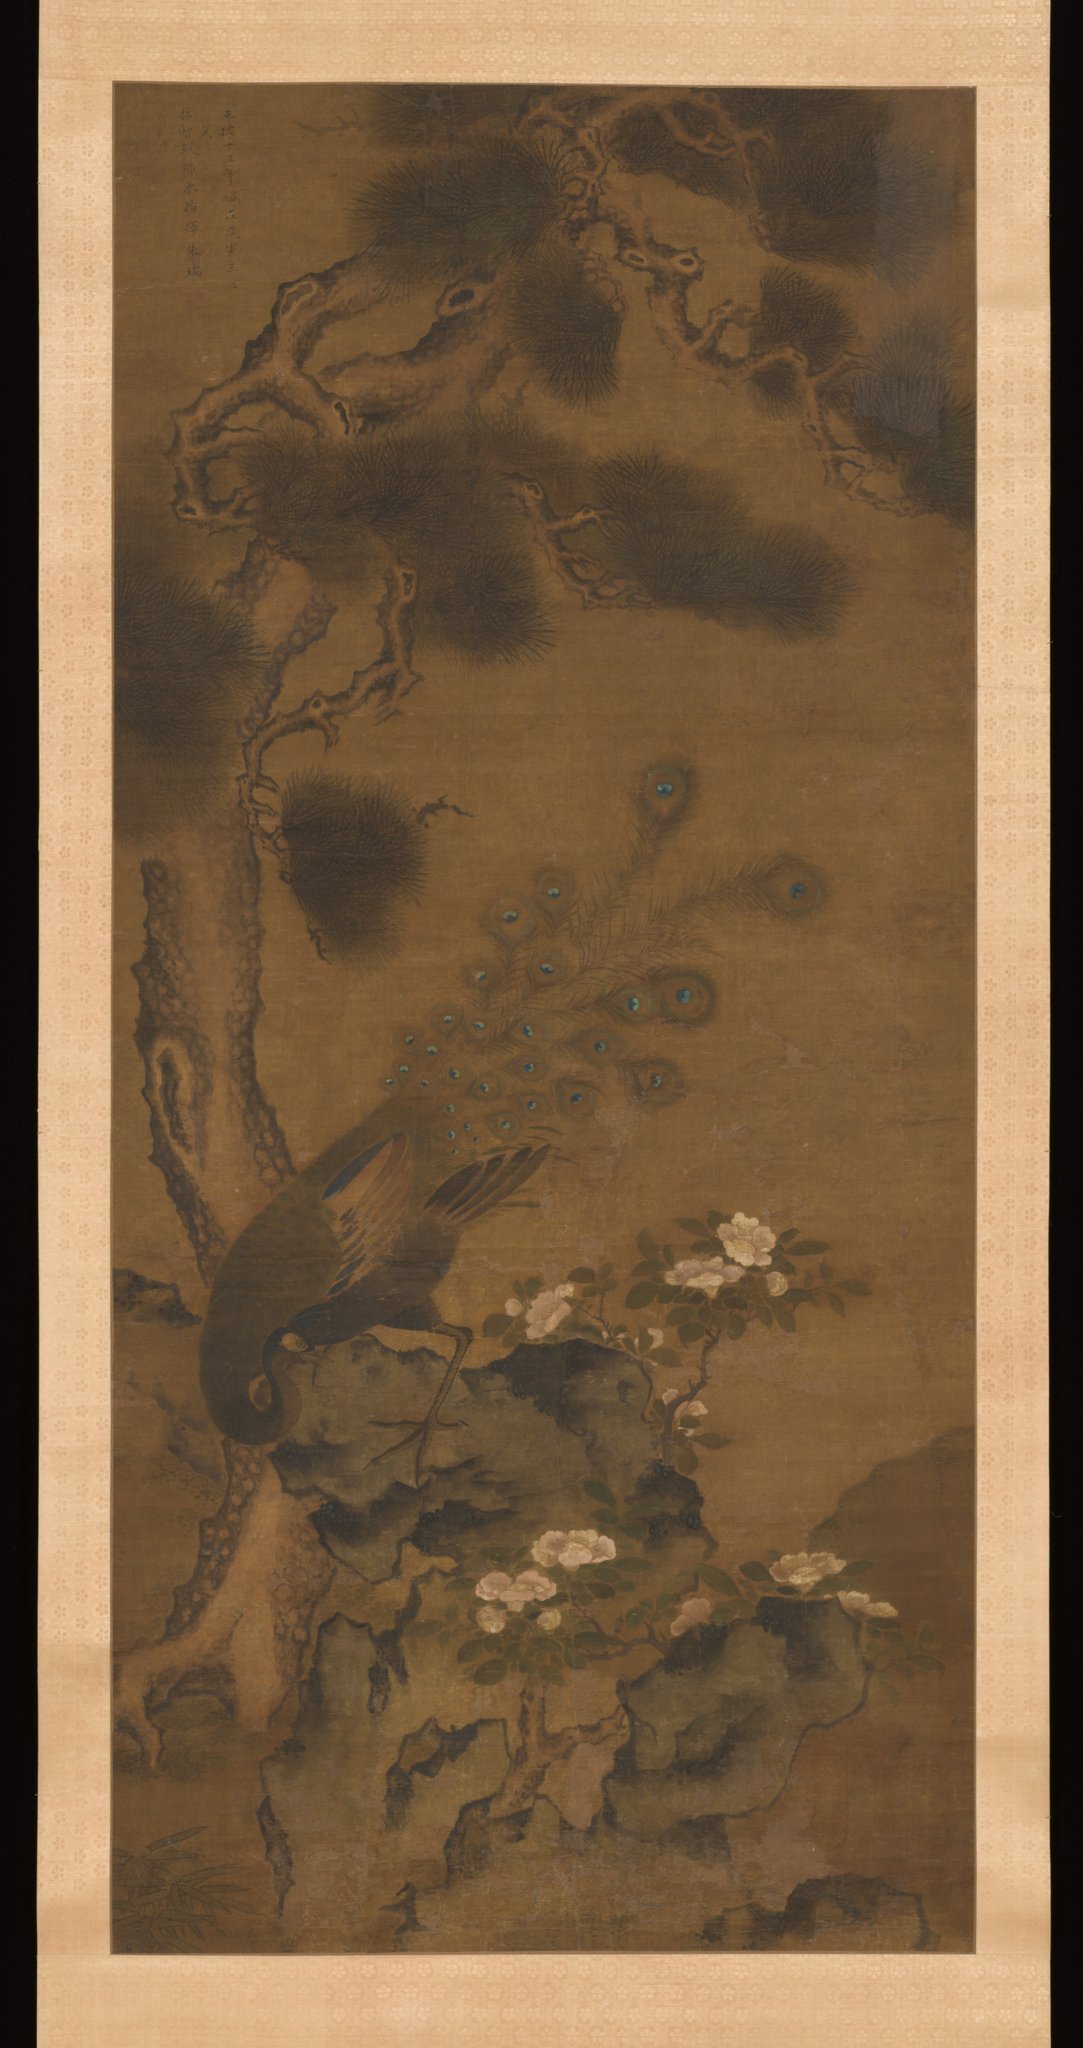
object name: hanging scroll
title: Peacock with Pine and Camellia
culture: chinese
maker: zhu duan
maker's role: artist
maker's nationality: chinese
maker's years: 1490-1531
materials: ink, silk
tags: peacocks